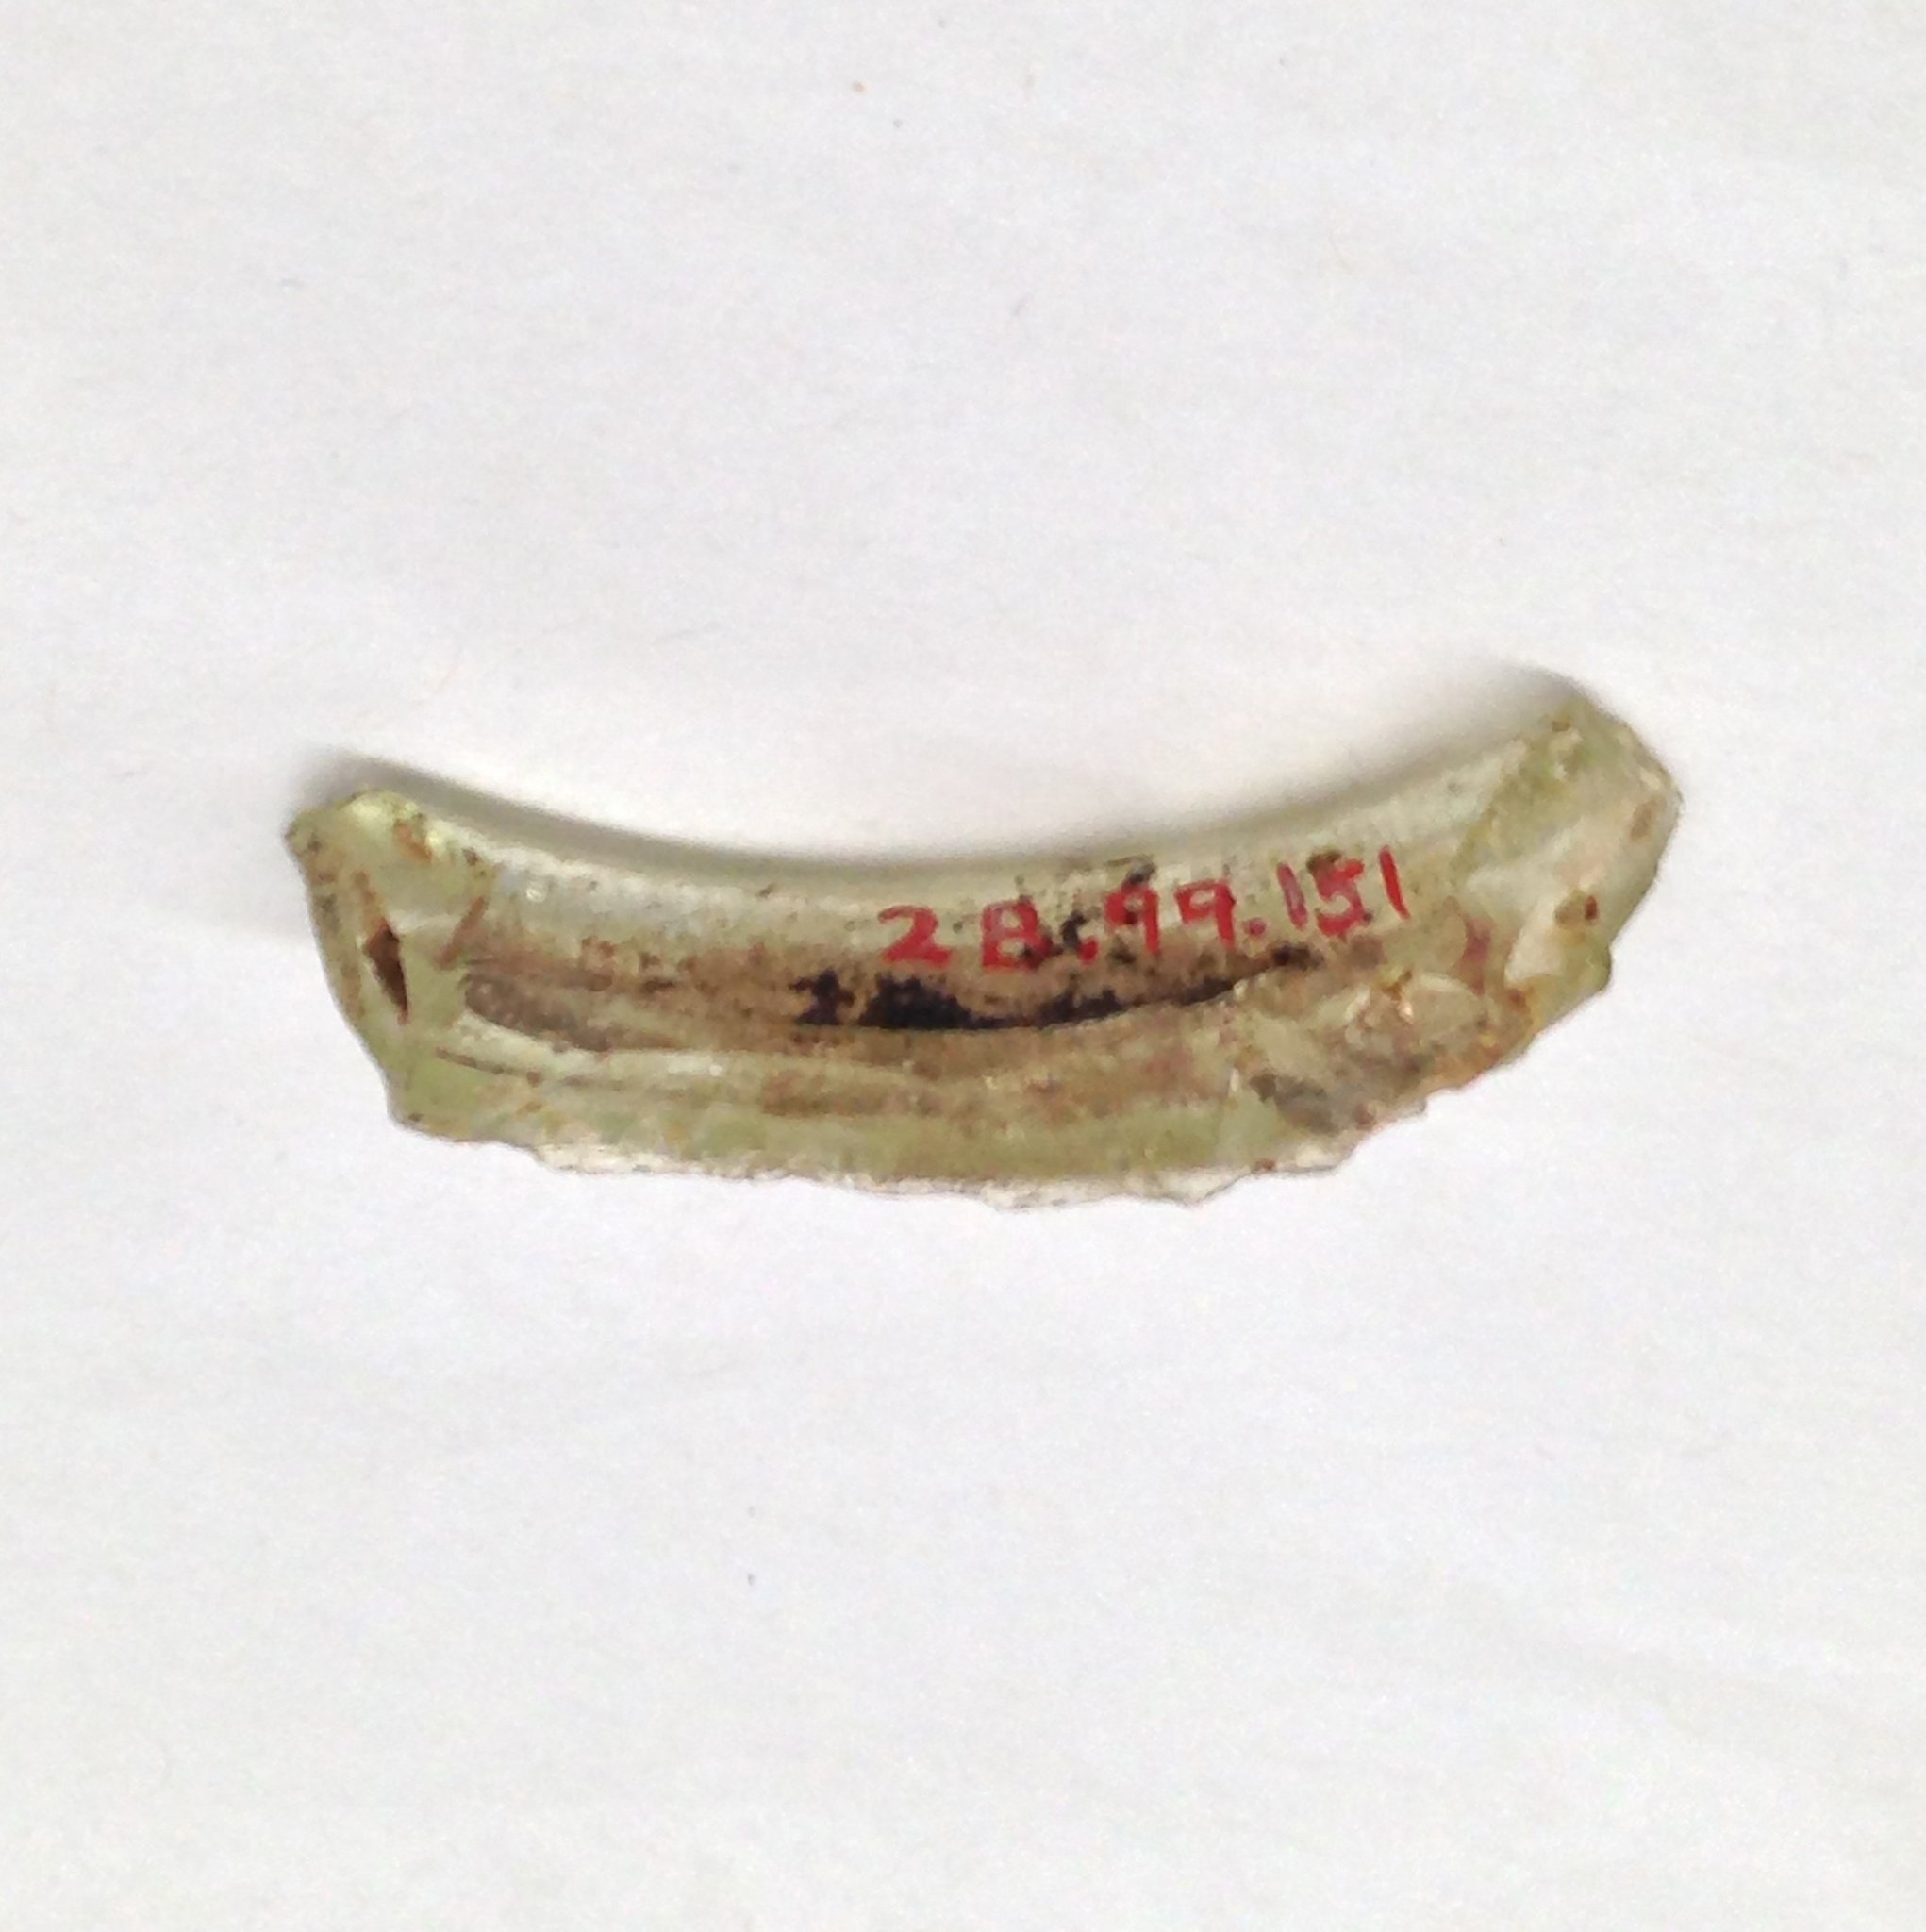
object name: fragment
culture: european or middle eastern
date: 1150-1250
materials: ceramic, glass